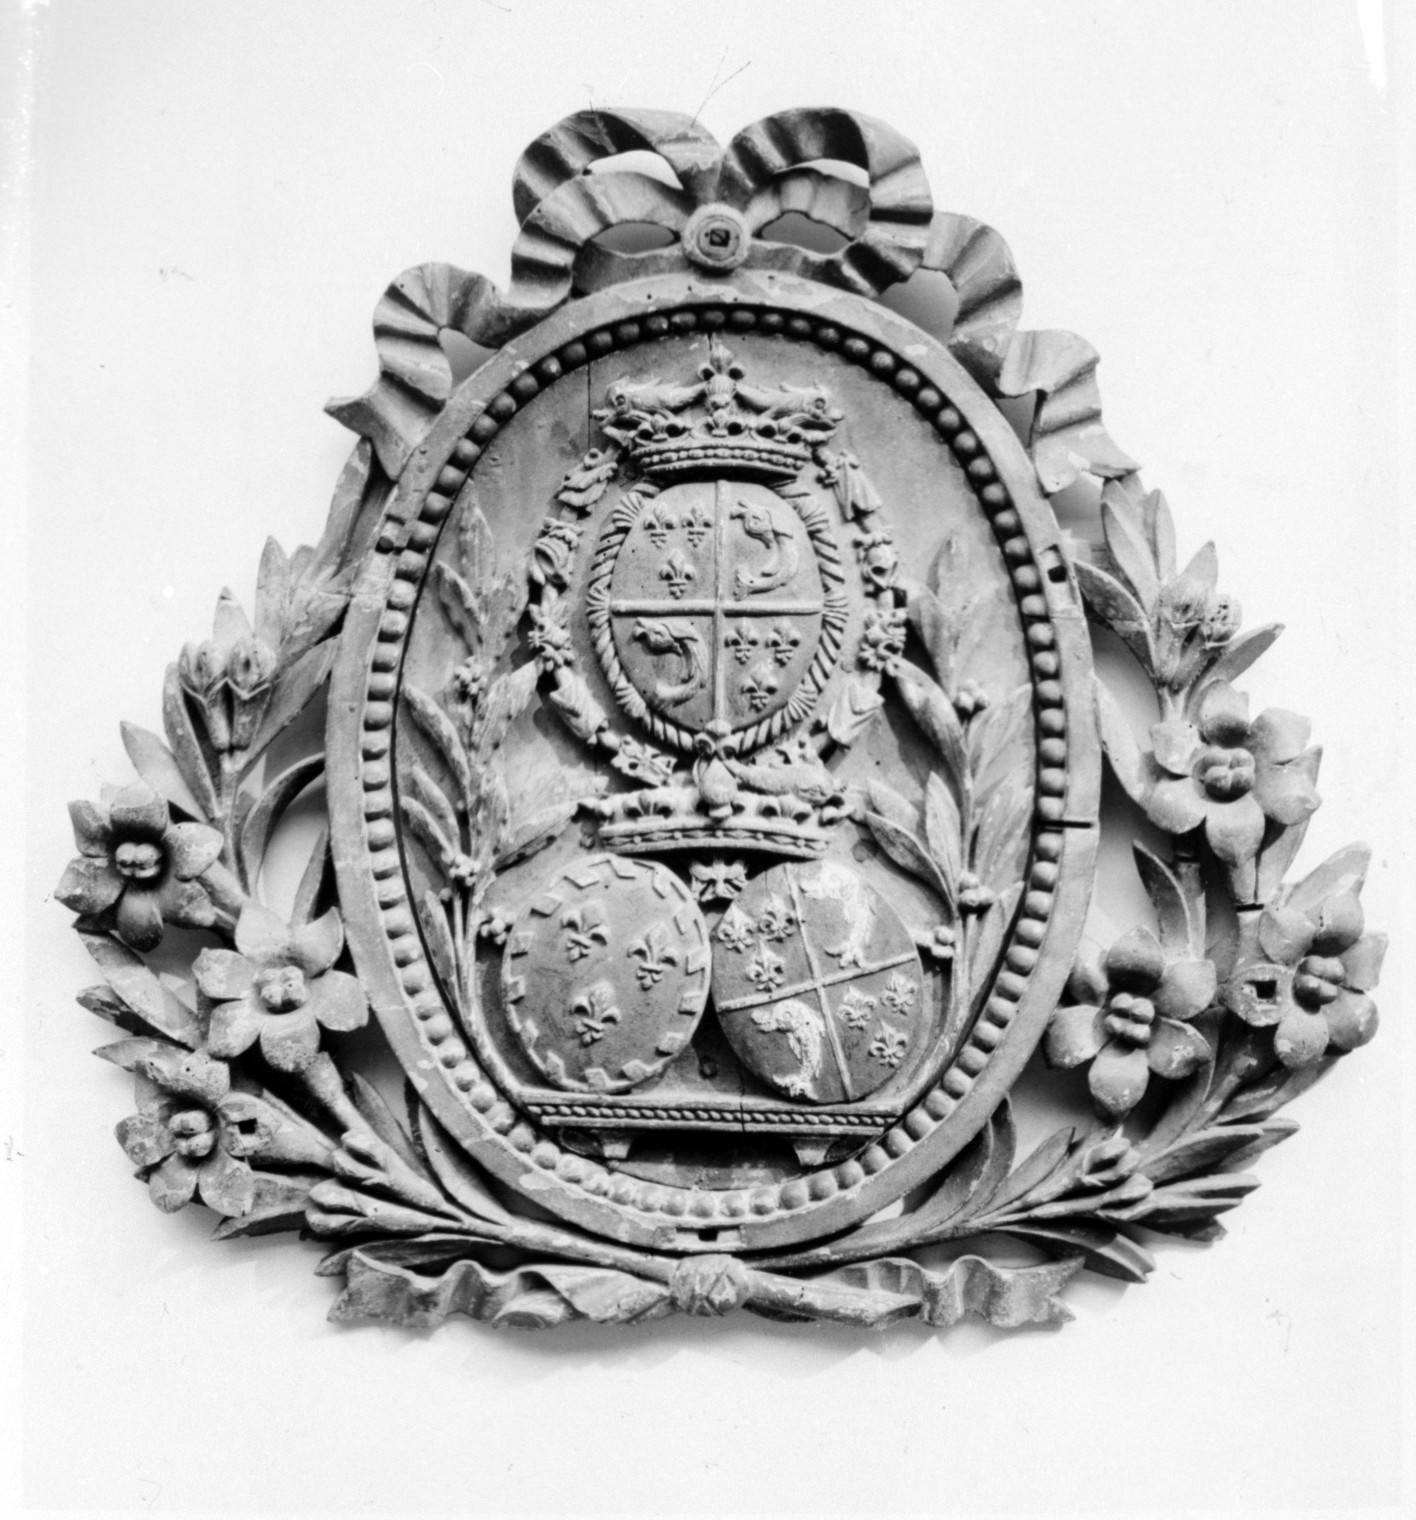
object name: panel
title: Coat of arms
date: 1824-1830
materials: wood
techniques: gilding, painting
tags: flowers,coat of arms